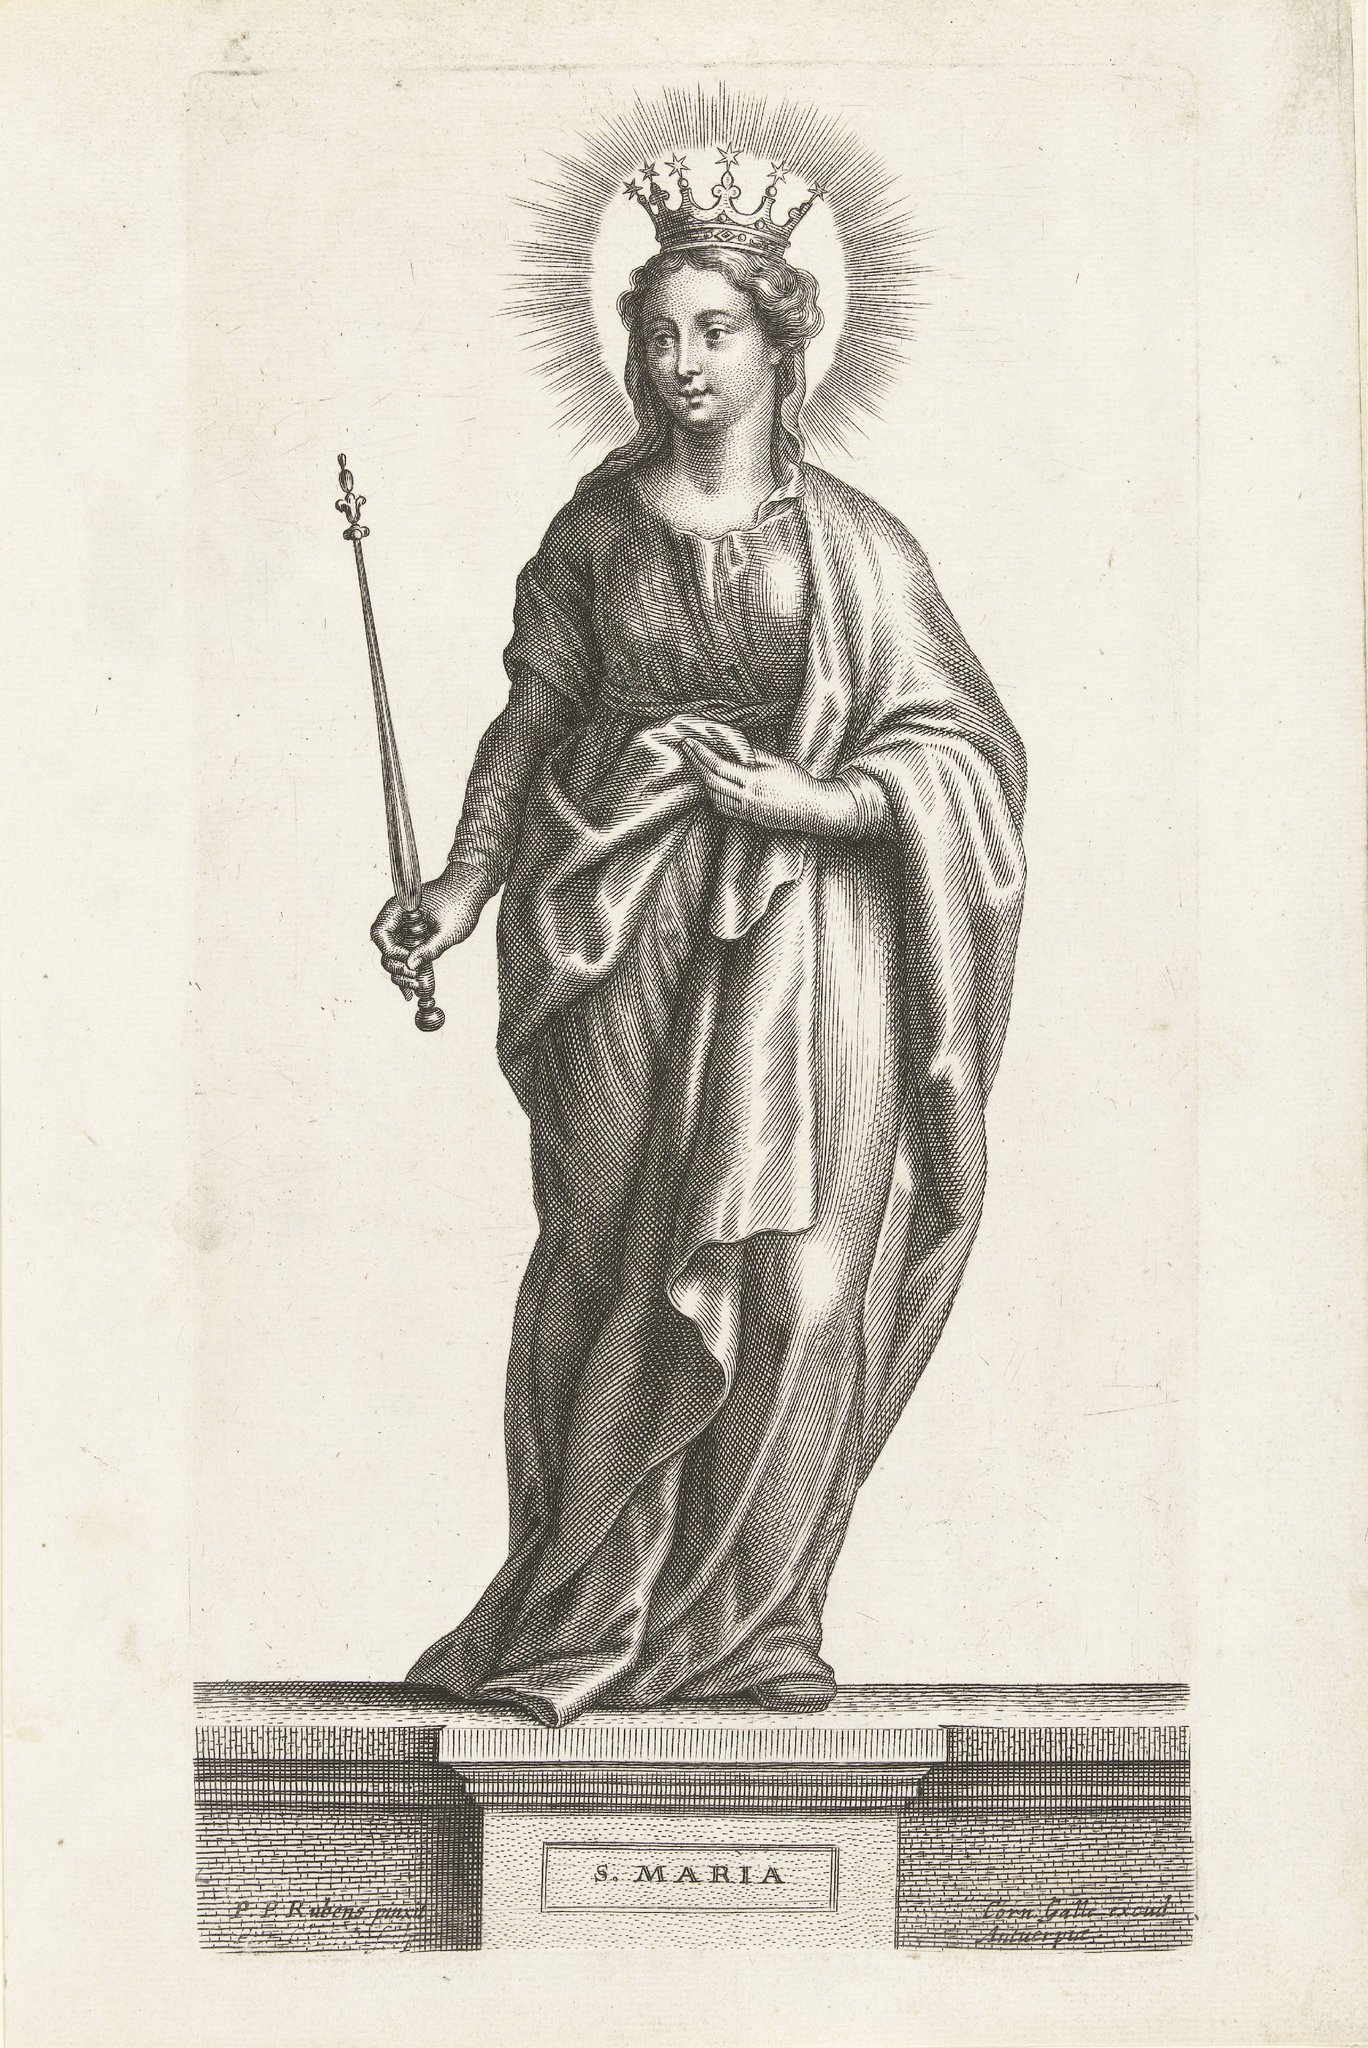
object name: print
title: SS Apostolorum Iconen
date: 1639-1670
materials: paper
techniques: engraving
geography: antwerp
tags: 'regina coeli', 'regina angelorum', 'maestà' ~ madonna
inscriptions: collector's mark: Lugt 2760, collector's mark: Lugt 2228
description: De prent toont de maagd Maria als koningin des wereld (Regina Coeli). In haar rechterhand een scepter. De serie bestaat uit prenten gebaseerd op schilderijen van Peter Paul Rubens.